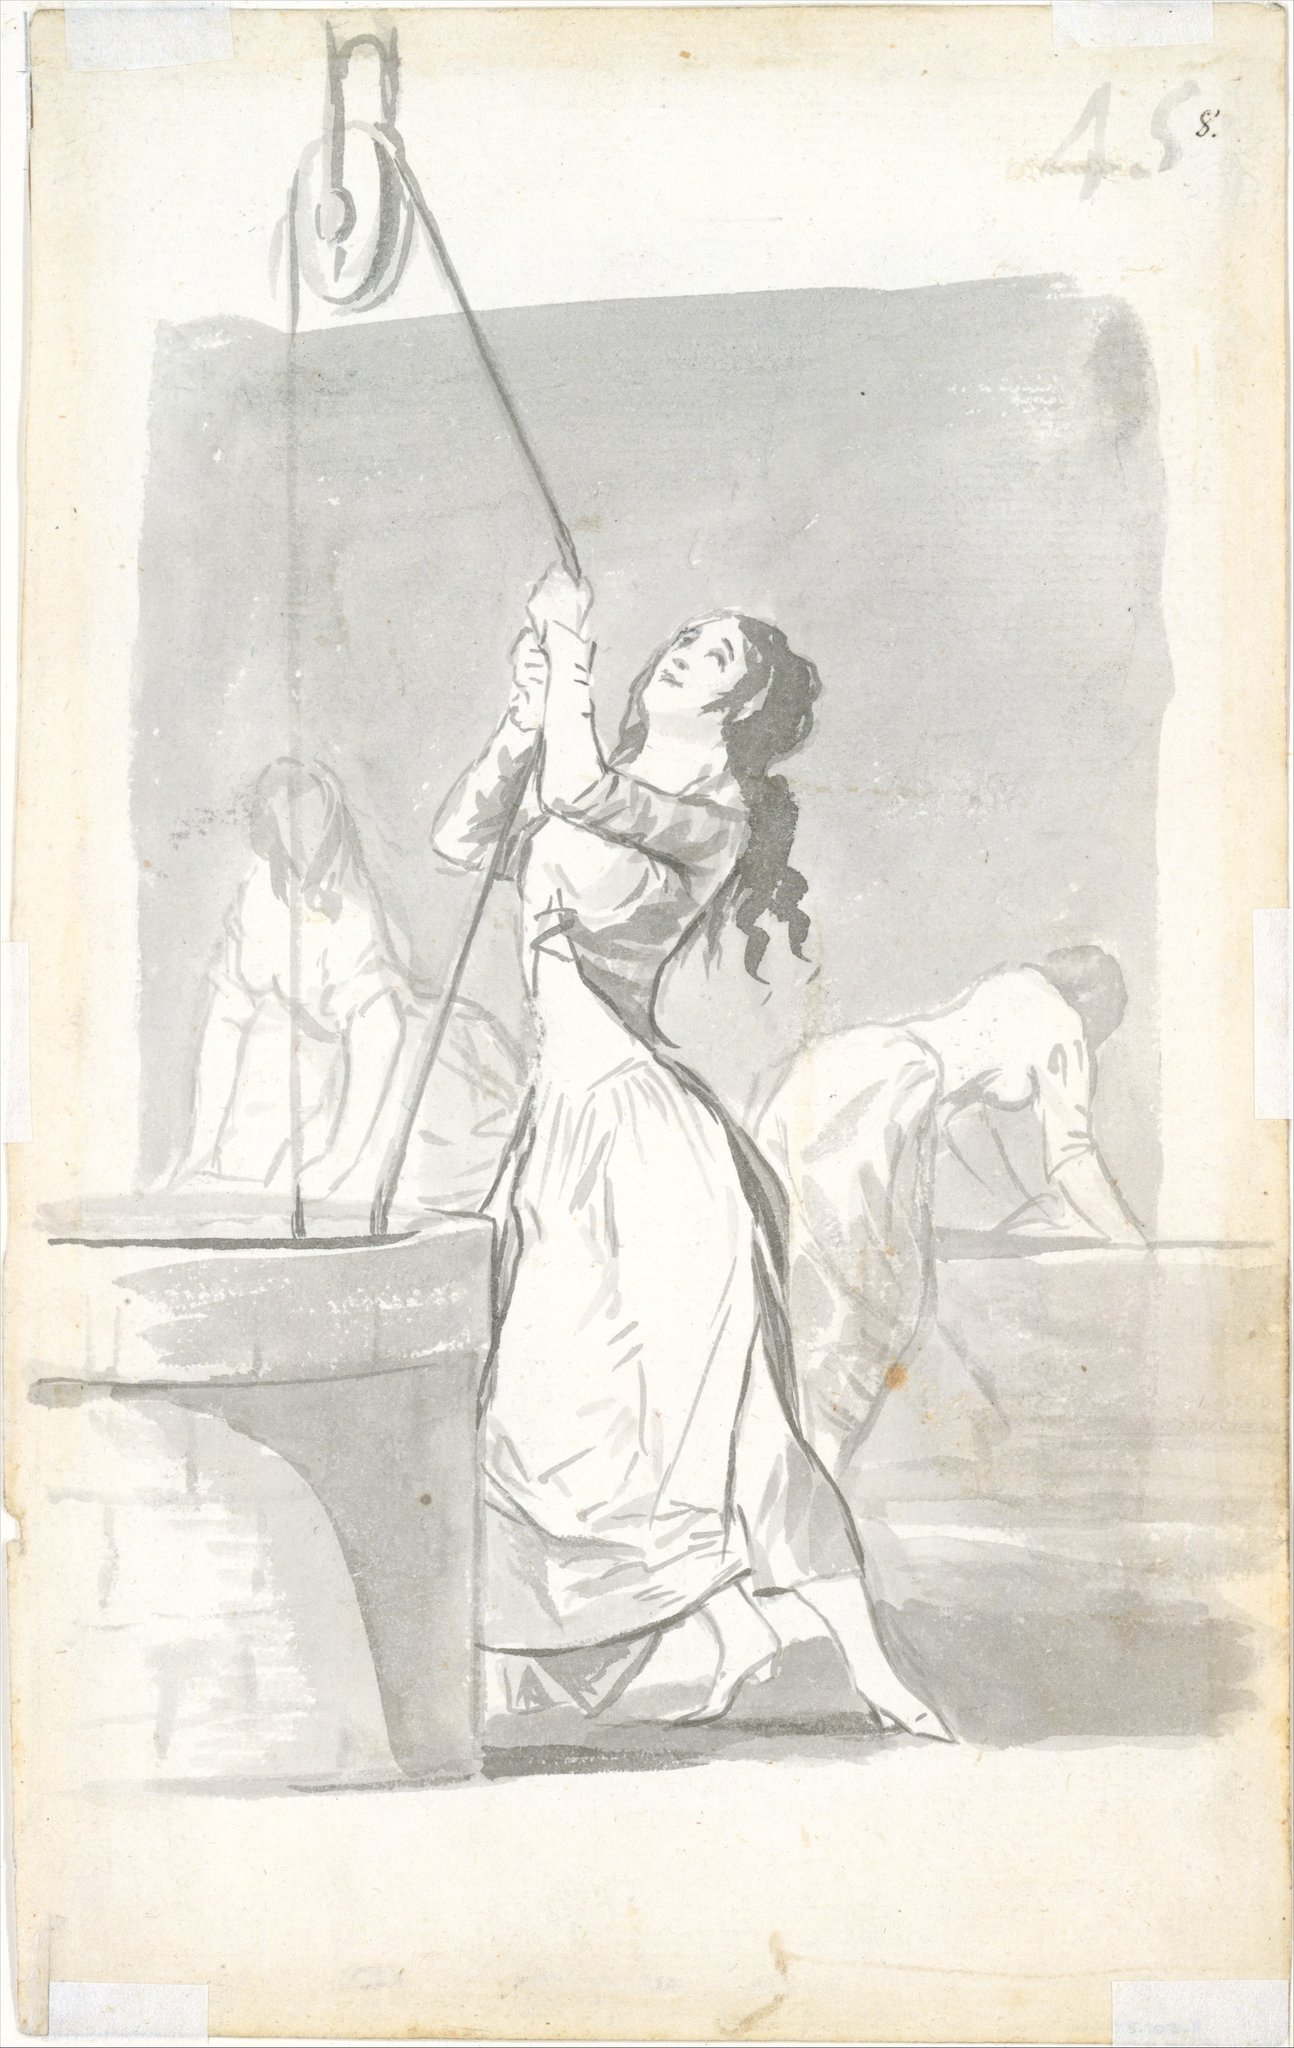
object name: drawing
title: Three women, one in the foreground drawing water from a well, two in the background washing; folio 45 (recto) from the Madrid Album "B"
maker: goya (francisco de goya y lucientes)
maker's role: artist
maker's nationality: spanish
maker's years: 1746-1828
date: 1795-1797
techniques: brush, wash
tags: wells,women,washing,working